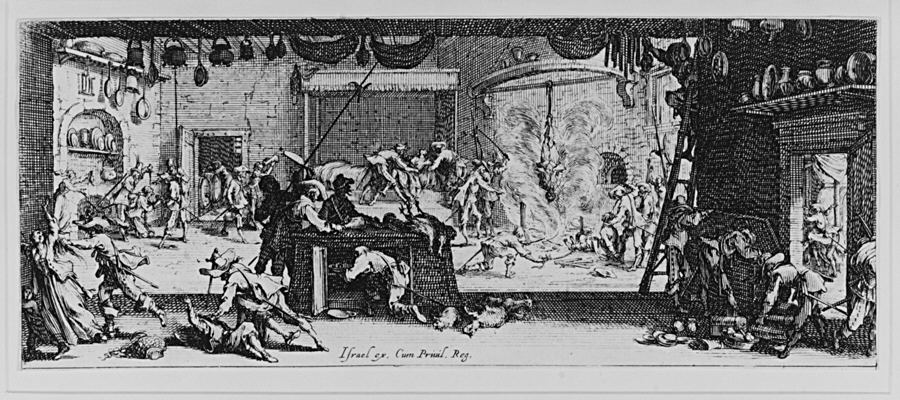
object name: print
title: Les Miseres Et Les Mal-Heurs De La Guerre... Israel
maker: jacques callot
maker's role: artist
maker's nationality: french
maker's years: 1592-1635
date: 1633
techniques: etching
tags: wars,weapons,men